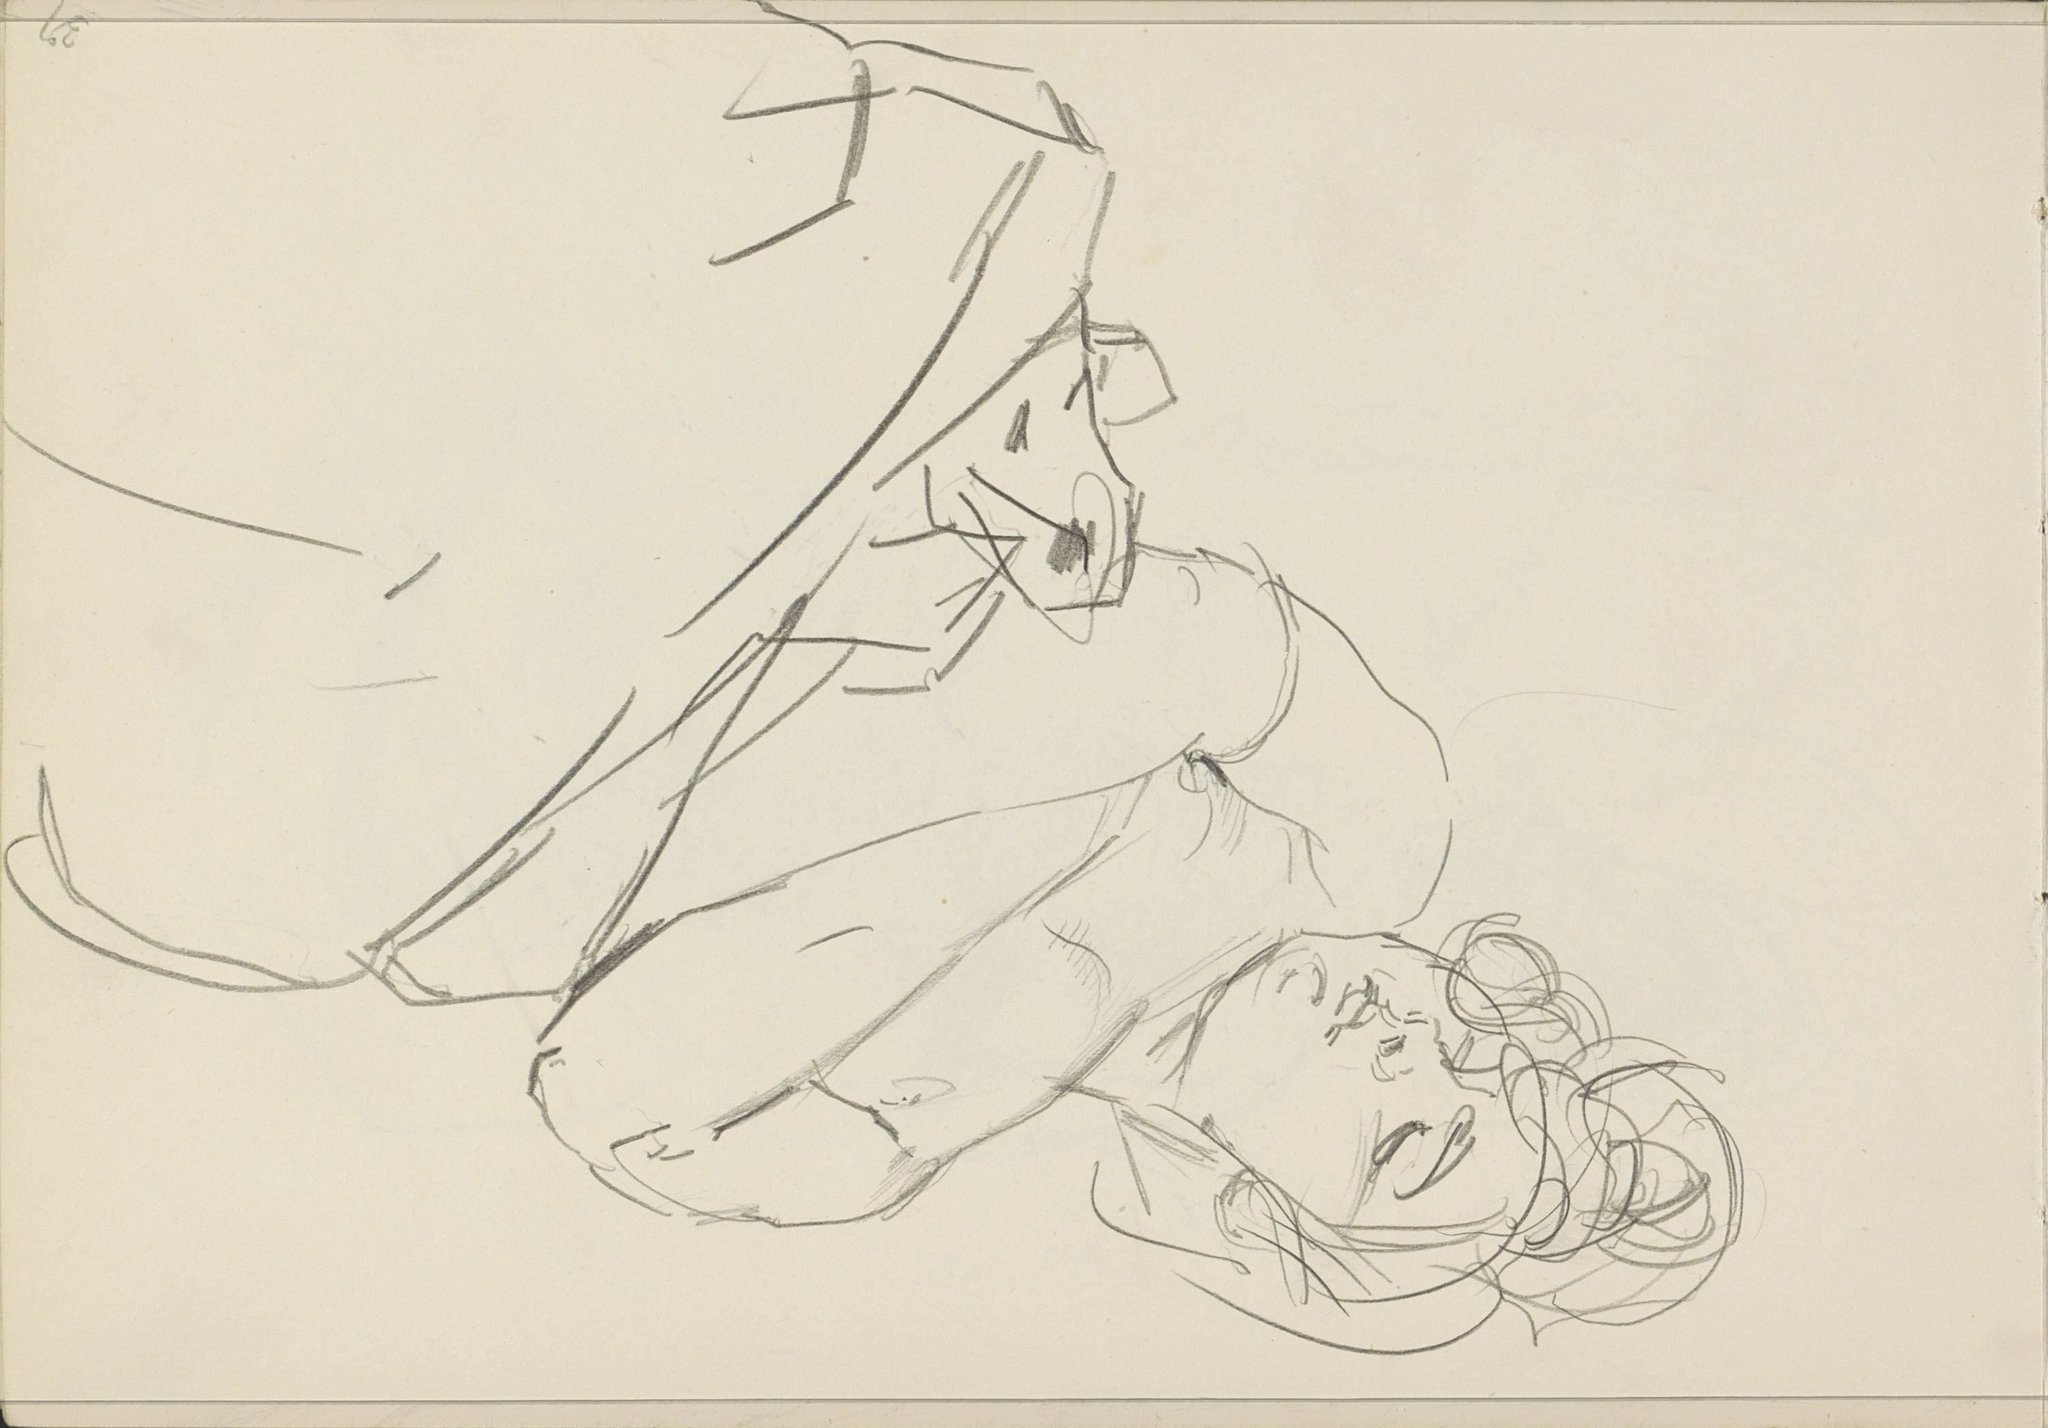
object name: sketchbook leaf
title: Slapende vrouw met ontbloot bovenlijf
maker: isaac israels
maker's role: draughtsman, painter, print maker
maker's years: 1865-1934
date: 1915-1934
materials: paper, pencil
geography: the hague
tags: the (nude) human figure; 'corpo humano' (ripa) - aa - female human figure (+ lying), sleeping; unconsciousness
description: Blad 11 verso uit schetsboek XXV met 23 bladen.